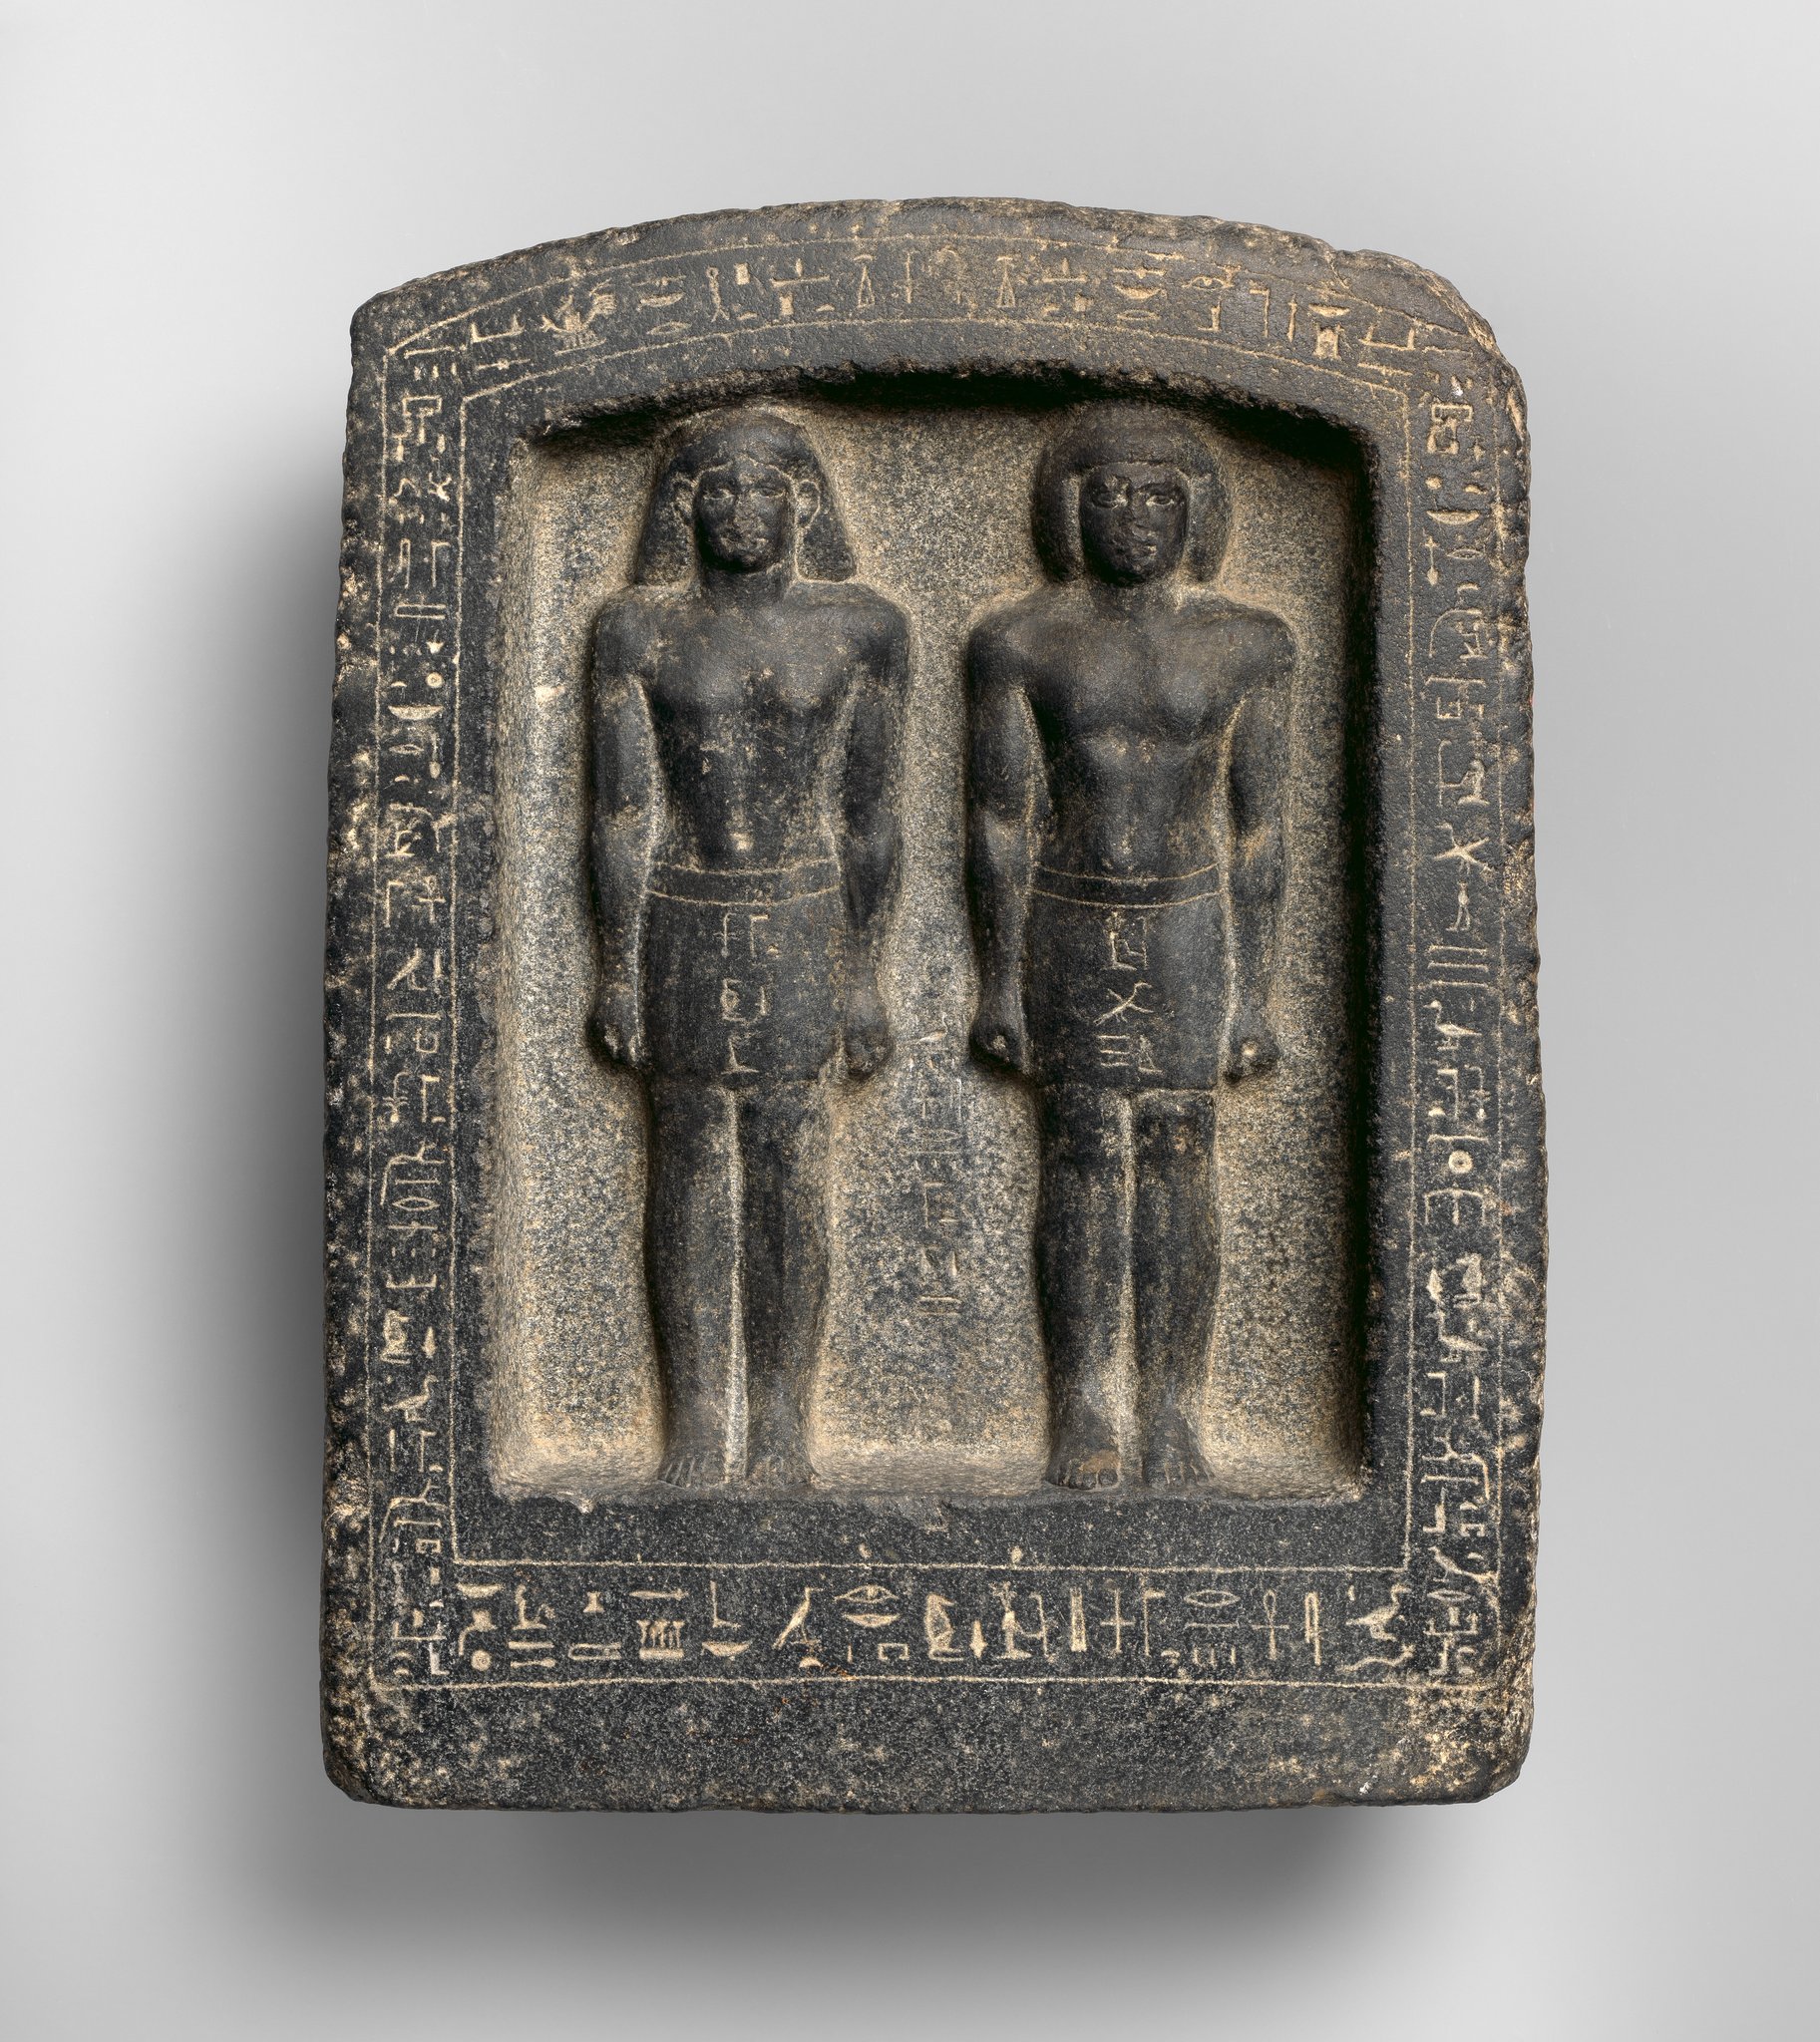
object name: stela, naos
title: Naos stela with Pa-inmu and his father It, son of Pedise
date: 664-610 BCE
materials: stone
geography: egypt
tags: men,hieroglyphs